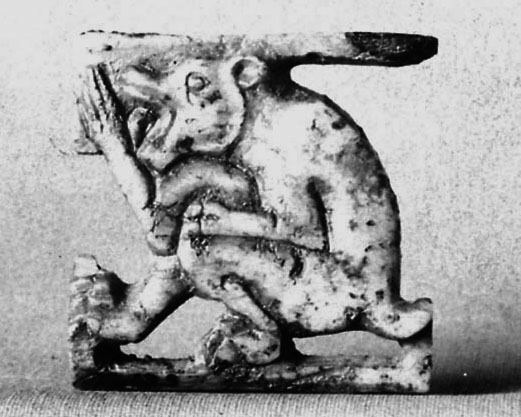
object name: plaque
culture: chinese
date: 206 BCE-220 CE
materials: bone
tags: mythical creatures